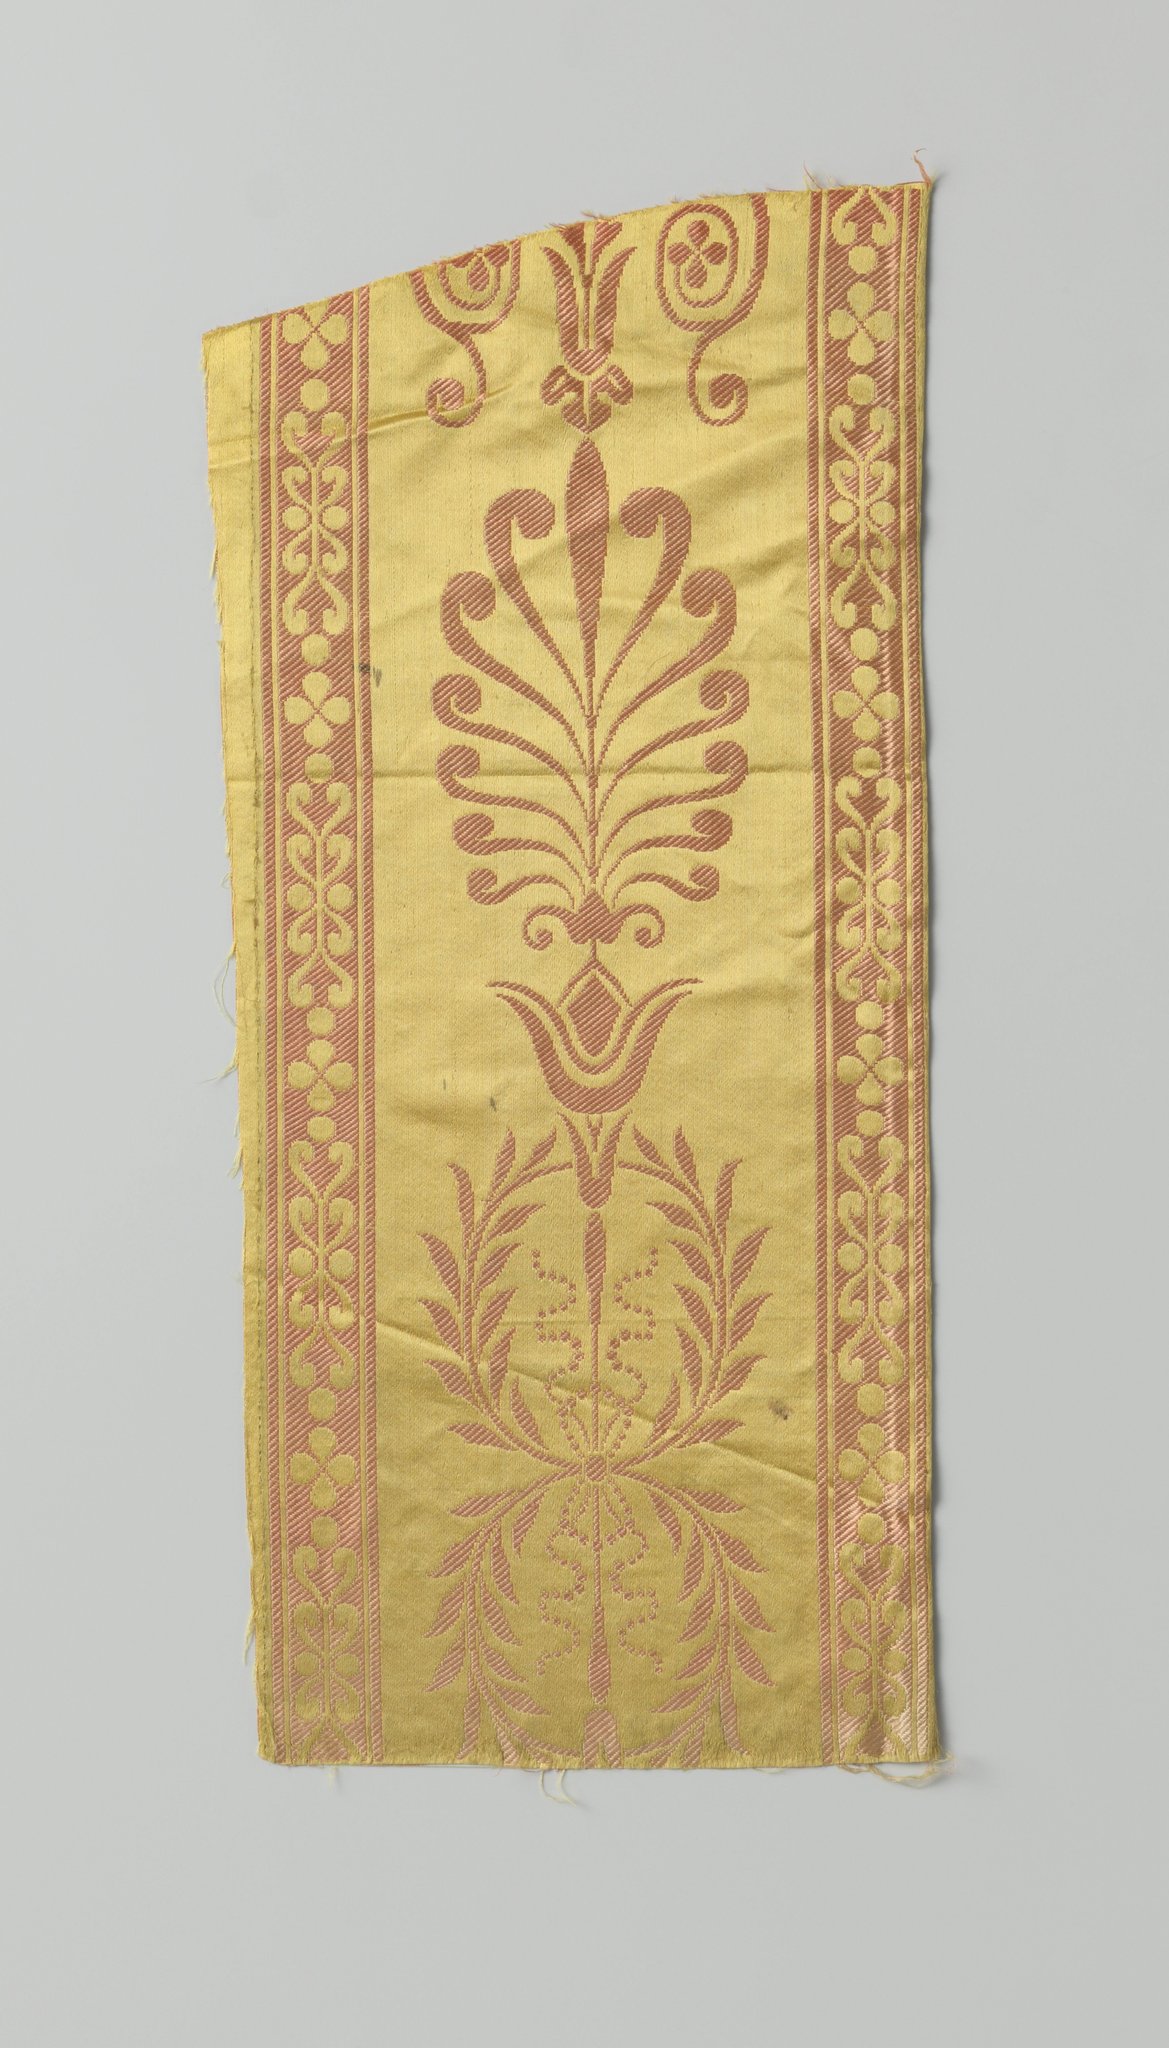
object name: stoelbekleding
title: Fragment zijdeweefsel van een stoelbekleding.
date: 1805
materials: silk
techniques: brocade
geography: france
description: Fragment geel zijdeweefsel, van een stoelbekleding. Het patroon heeft op een gele grond roze palmetten en arabesken. Het fragment hoort bij dertien fragmenten met invnr. BK-1992-18-A t/m BK-1992-18-M.